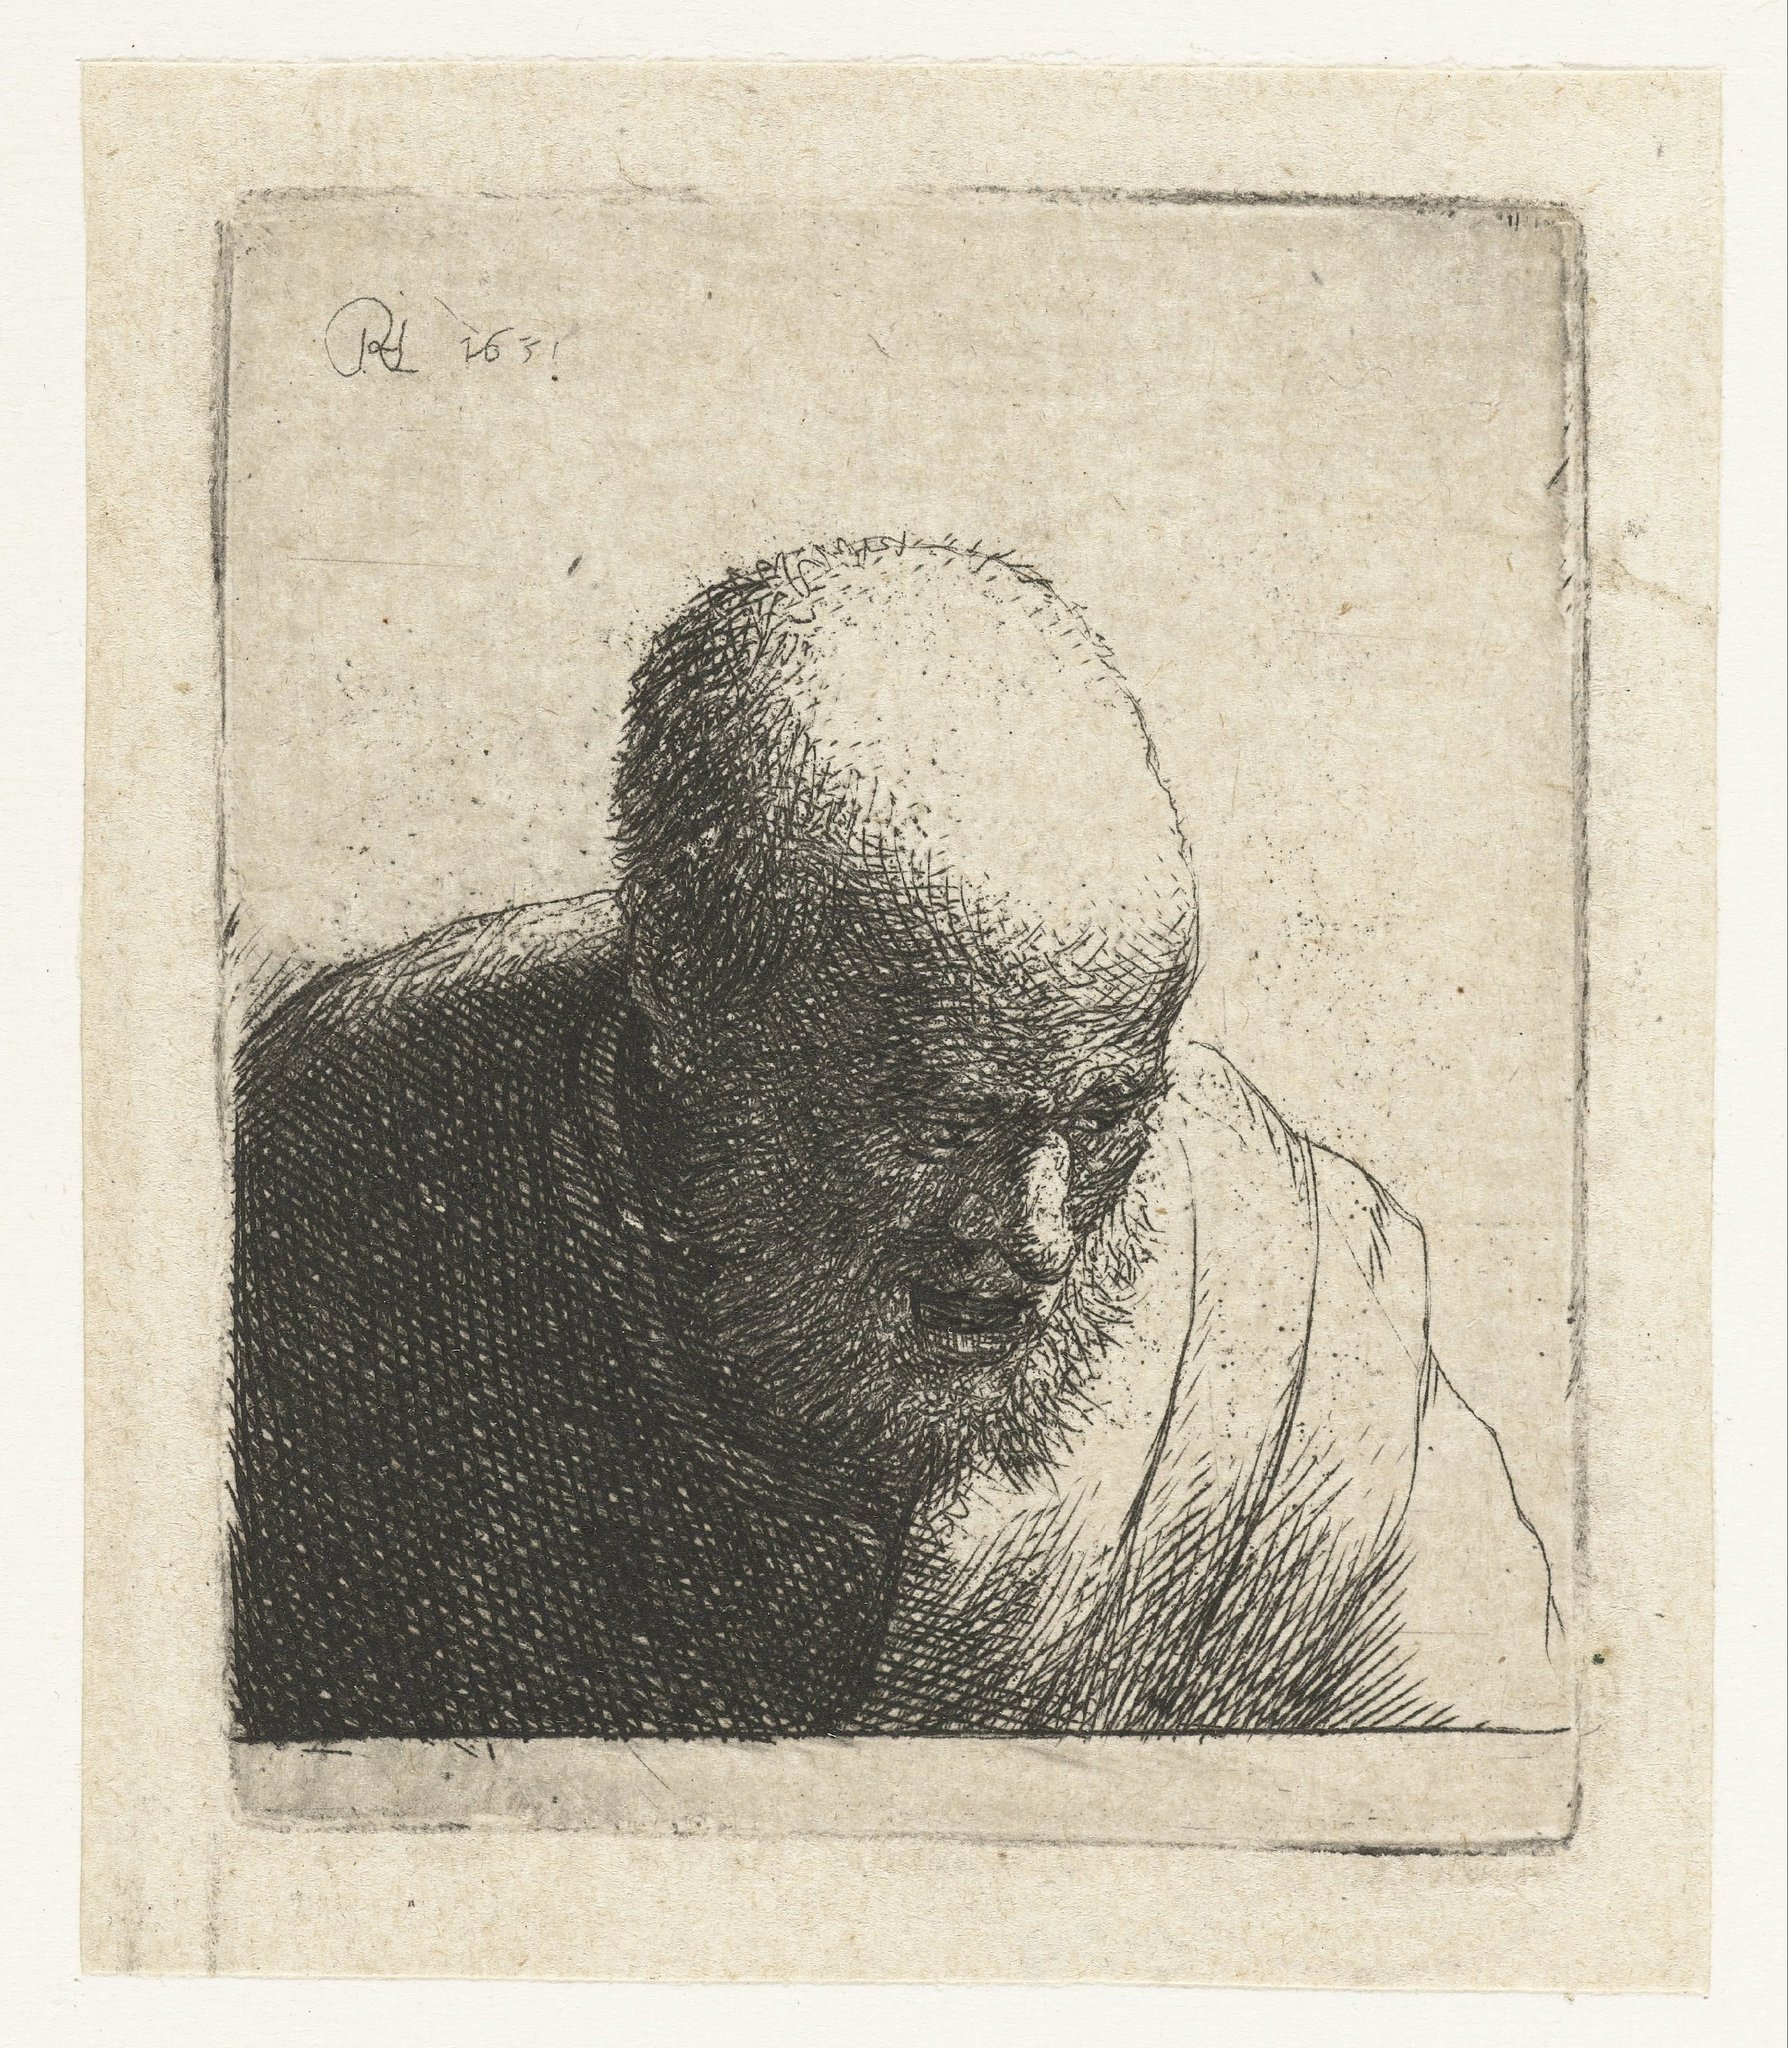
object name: print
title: Bald man with open mouth, looking down: bust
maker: rembrandt van rijn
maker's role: draughtsman, painter, print maker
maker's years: 1606-1669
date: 1631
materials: paper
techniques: engraving, etching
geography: netherlands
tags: baldness, old man (+ downward)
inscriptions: collector's mark: Lugt 240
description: De plaat is opgewerkt door een andere hand, mogelijk Jan Gillisz. van Vliet.